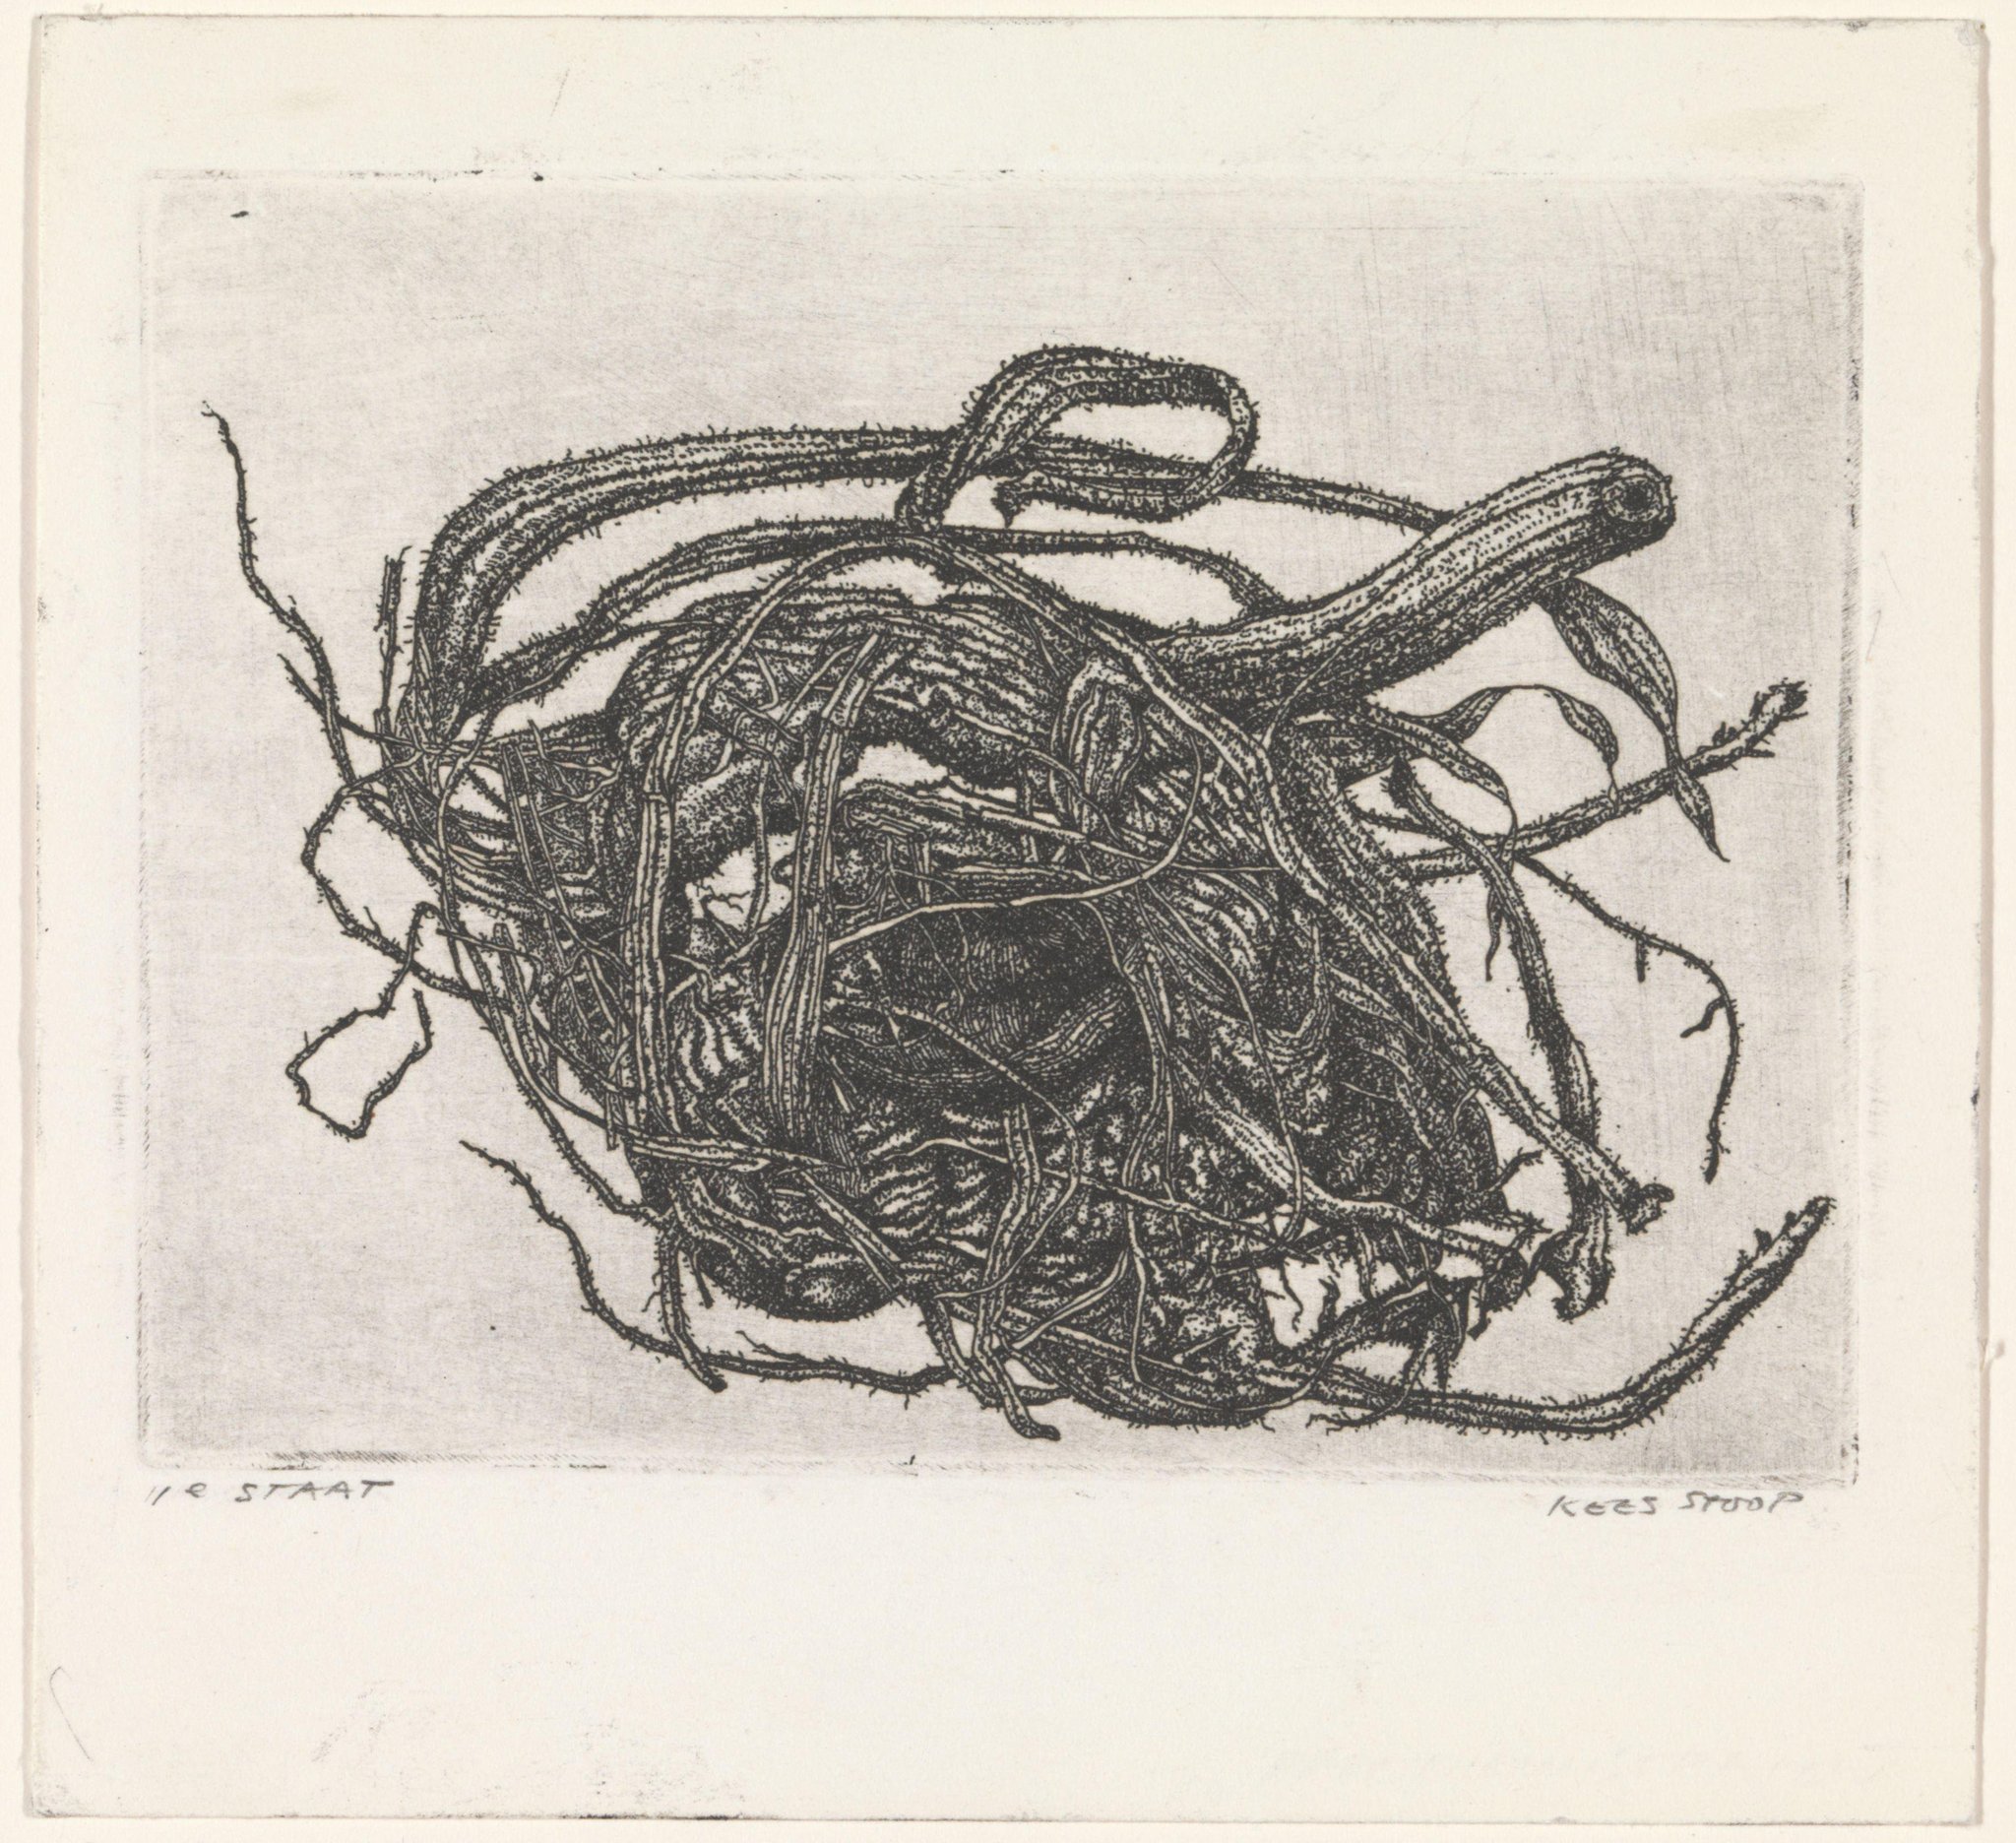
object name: print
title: Kluwen takken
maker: kees stoop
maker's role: draughtsman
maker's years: 1929-2019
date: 1970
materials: paper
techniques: etching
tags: trees (+ root, tuber)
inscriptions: inscription: ‘1e STAAT’, signature: ‘KEES STOOP’